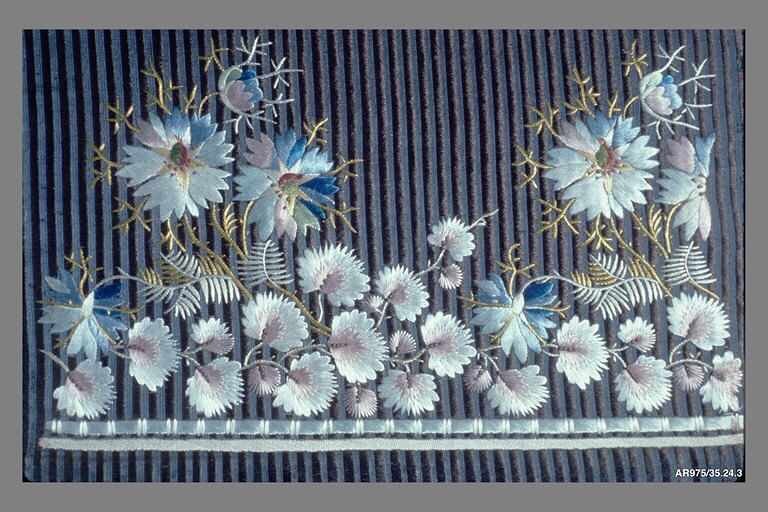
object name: sample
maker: jean françois bony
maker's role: designer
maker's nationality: french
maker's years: 1760-1825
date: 1767-1833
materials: silk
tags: flowers